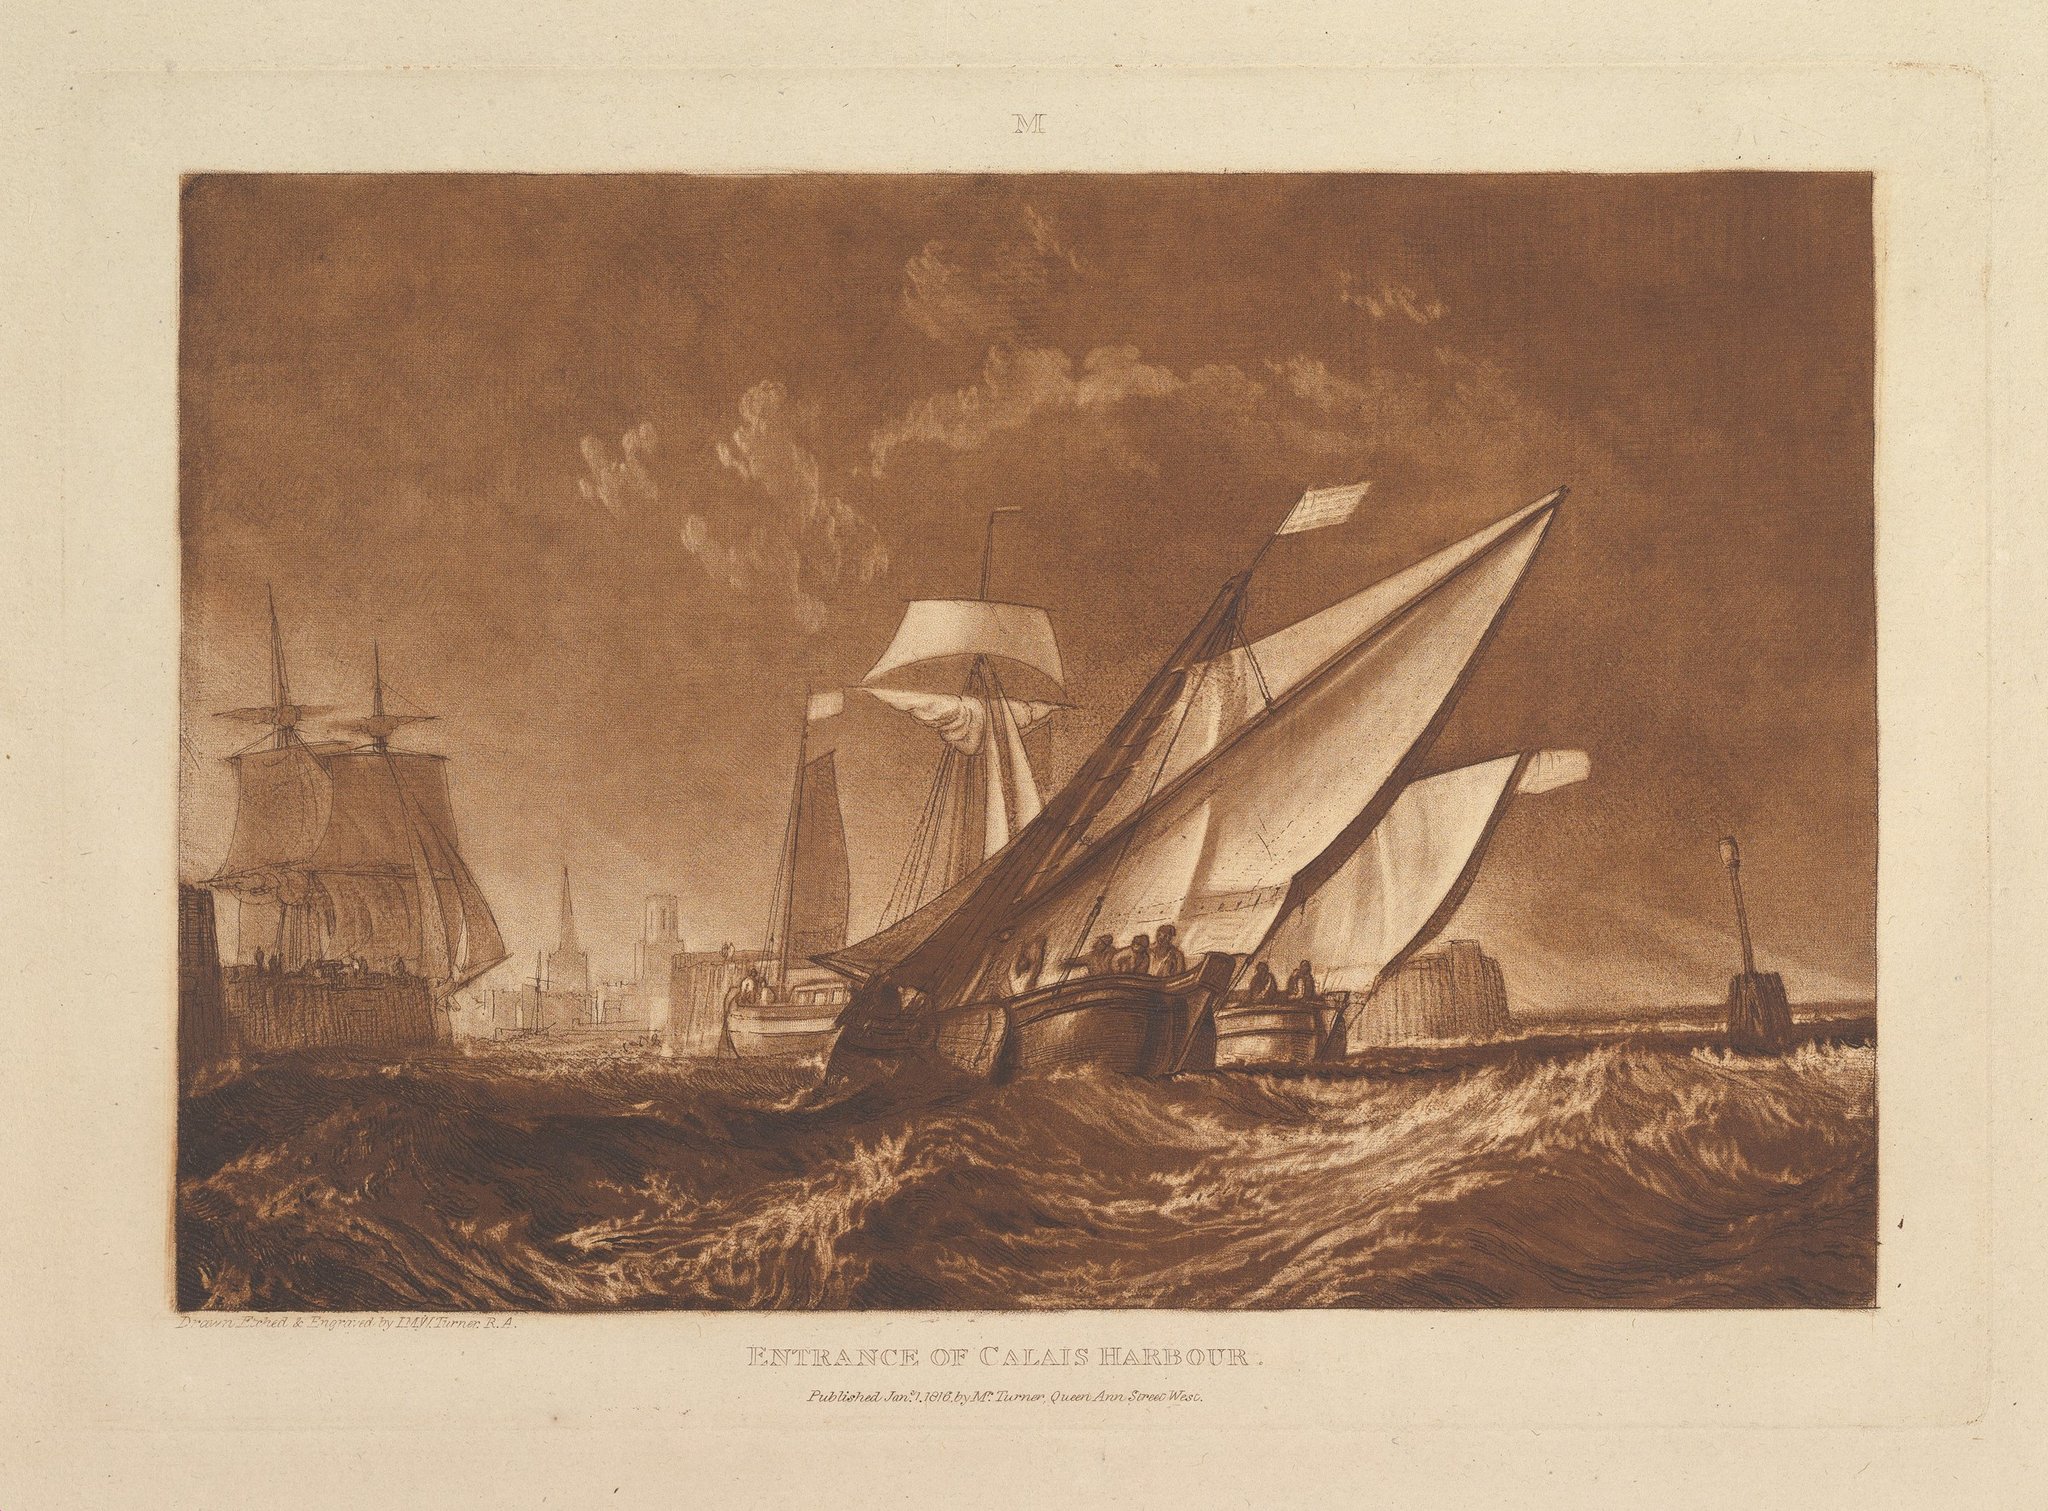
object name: print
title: Entrance of Calais Harbour, part XI, plate 55 from "Liber Studiorum"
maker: joseph mallord william turner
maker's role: artist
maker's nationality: british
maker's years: 1775-1851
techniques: aquatint, etching, mezzotint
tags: seascapes,ships